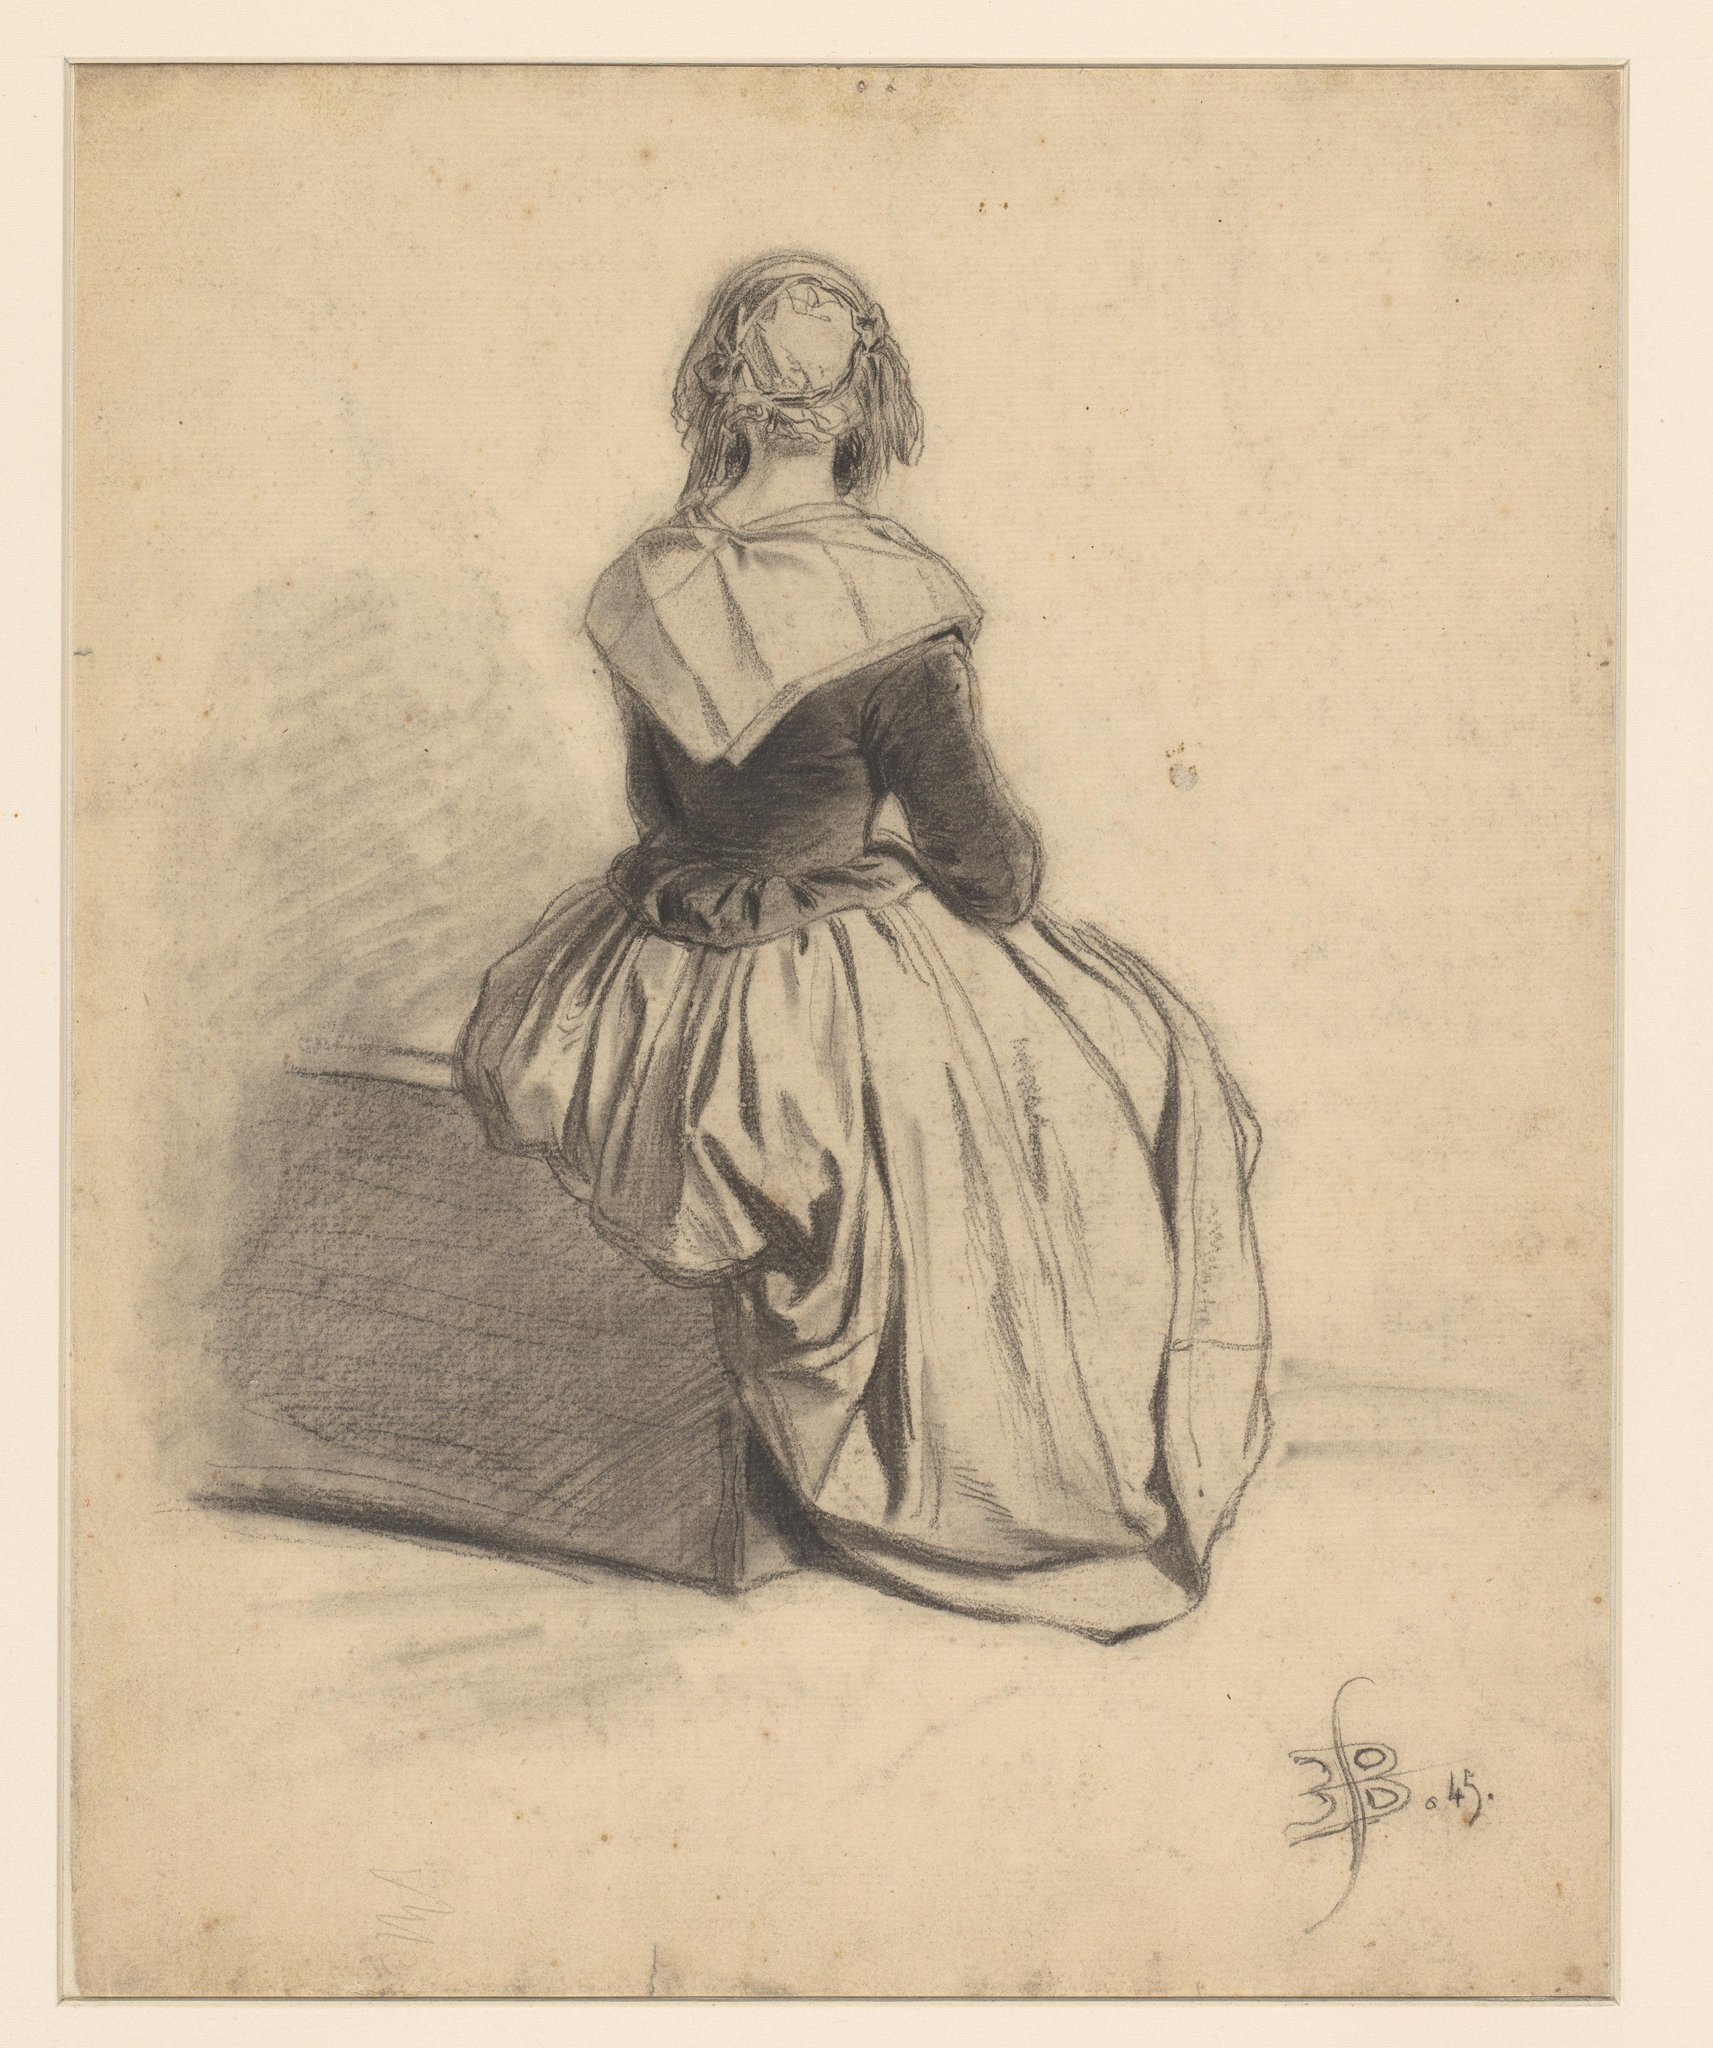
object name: drawing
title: Vrouw zittend op een kist, op de rug gezien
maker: eugène françois de block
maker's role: draughtsman, painter, print maker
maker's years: 1812-1893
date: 1845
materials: chalk, paper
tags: sitting figure - aa - female human figure